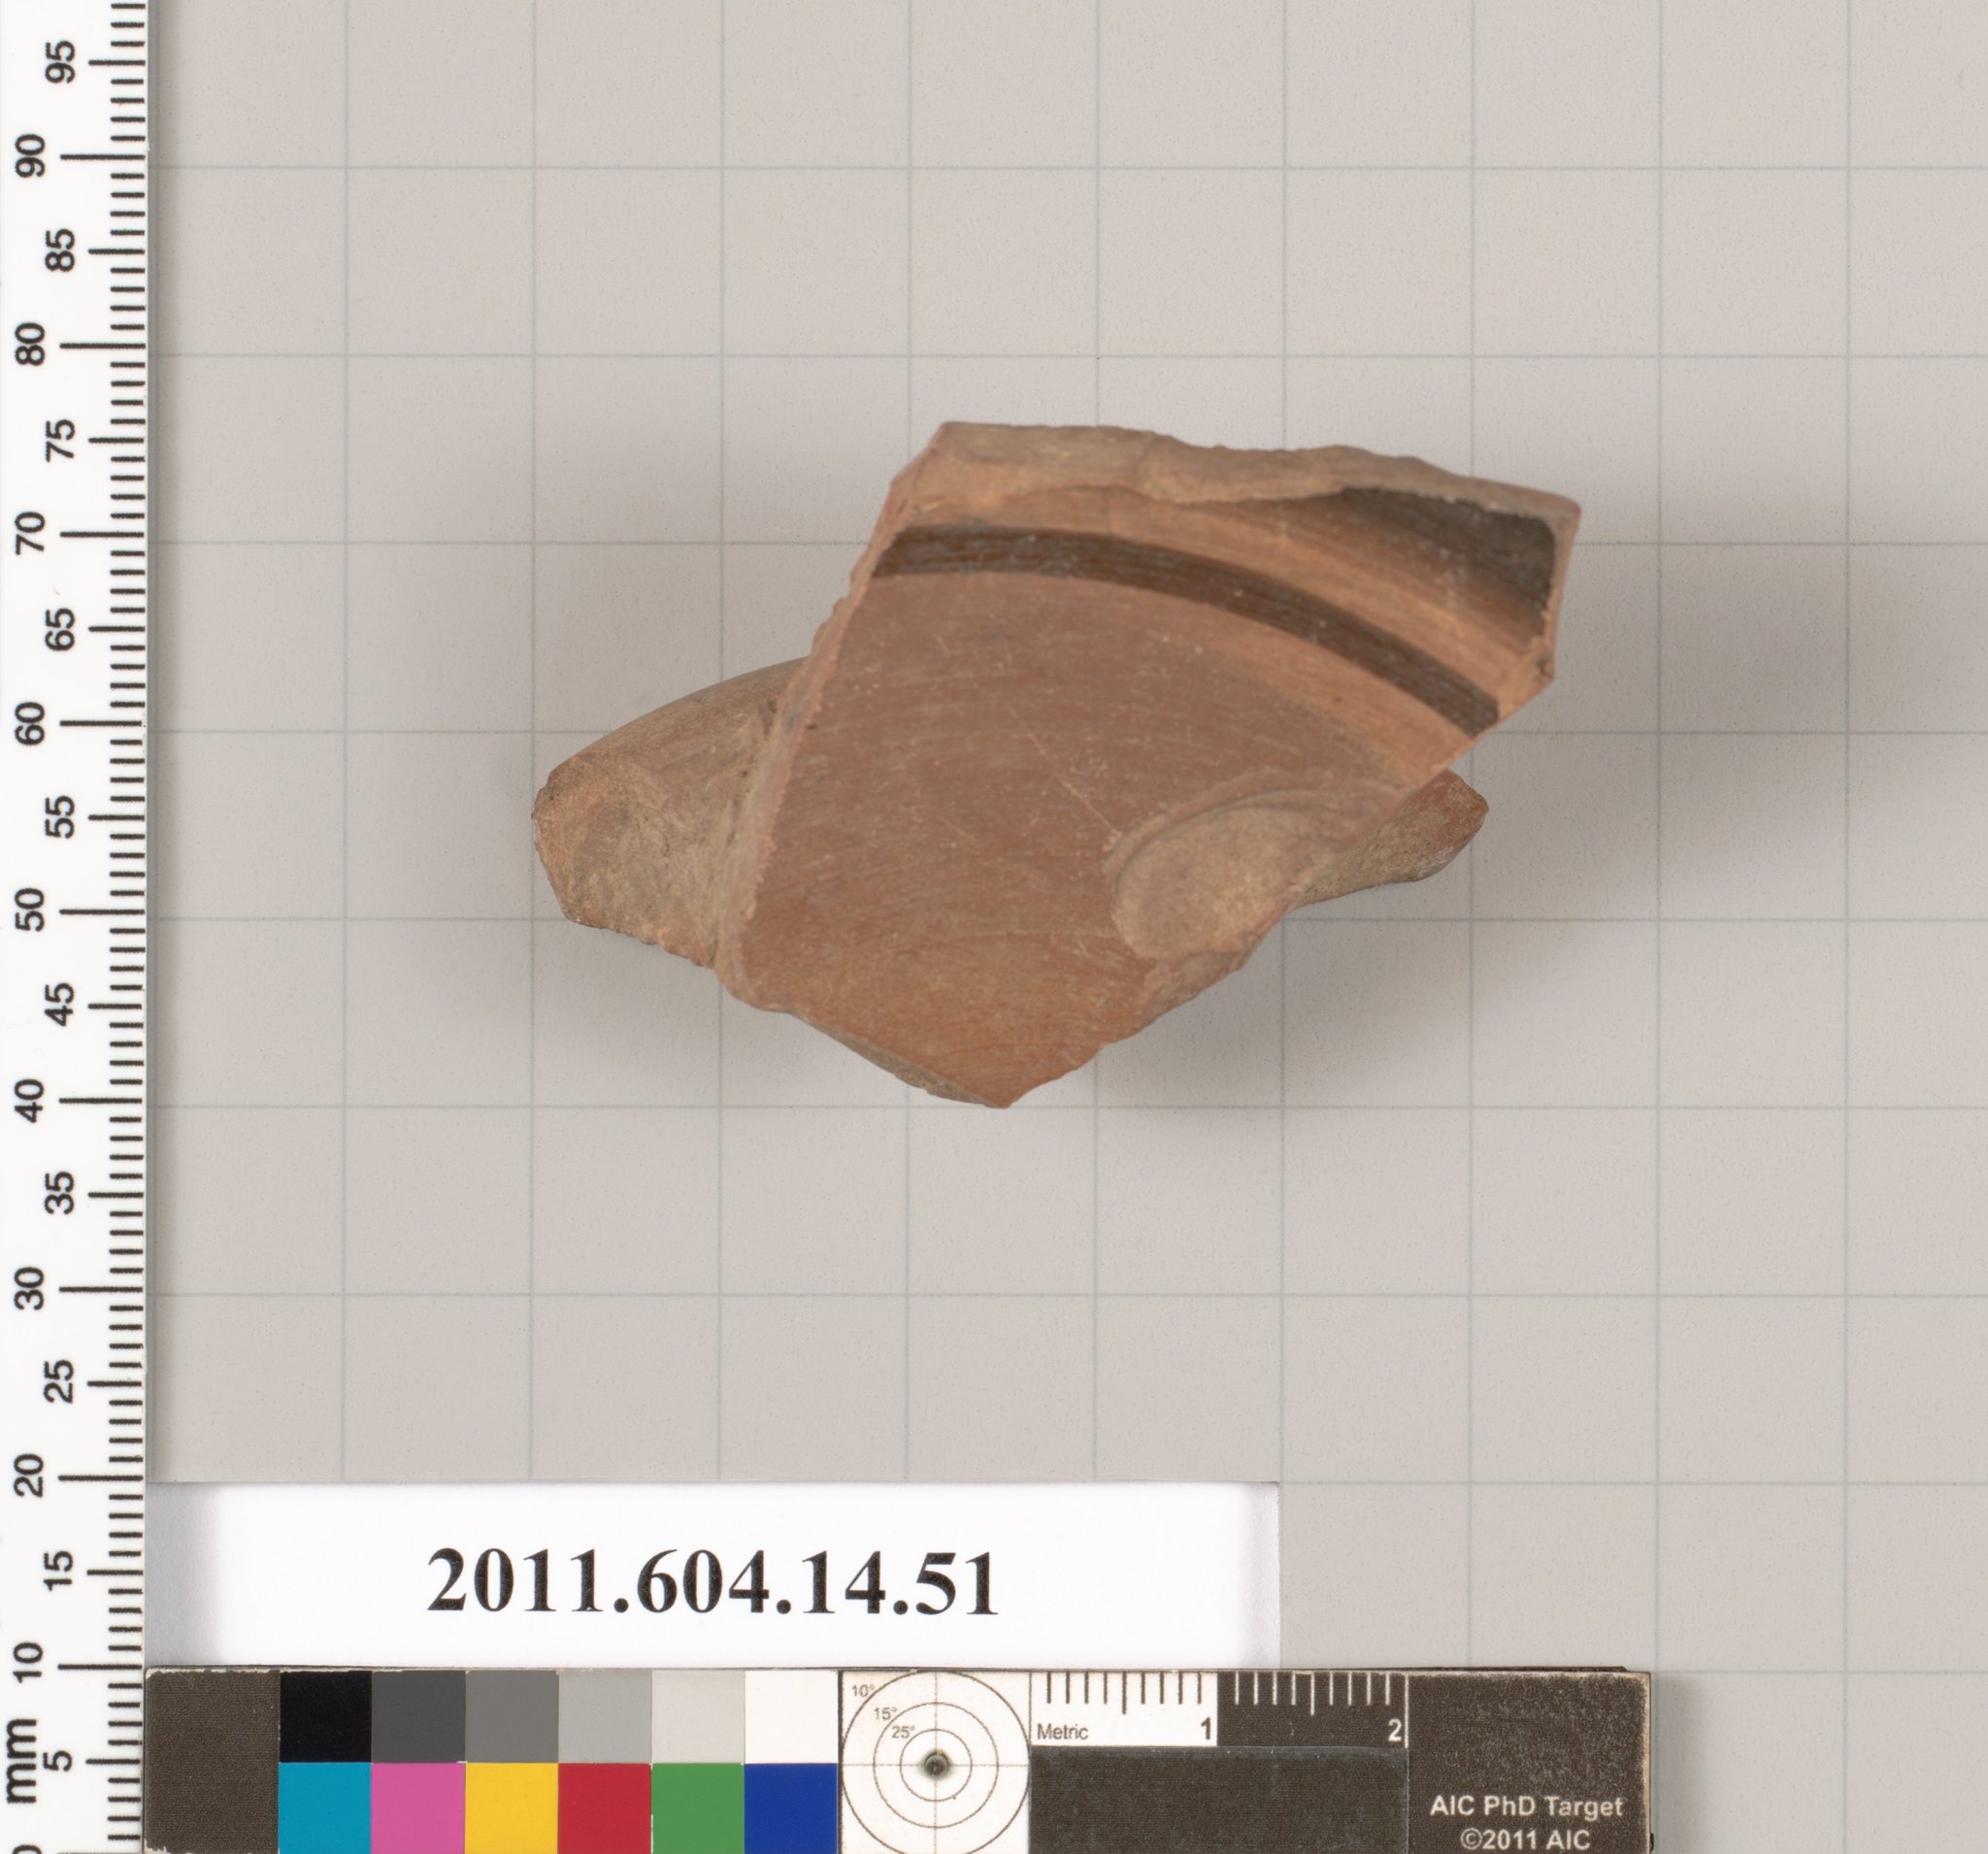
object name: fragment of a bowl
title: Terracotta fragment of a bowl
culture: unknown fabric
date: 600-301 BCE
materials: terracotta